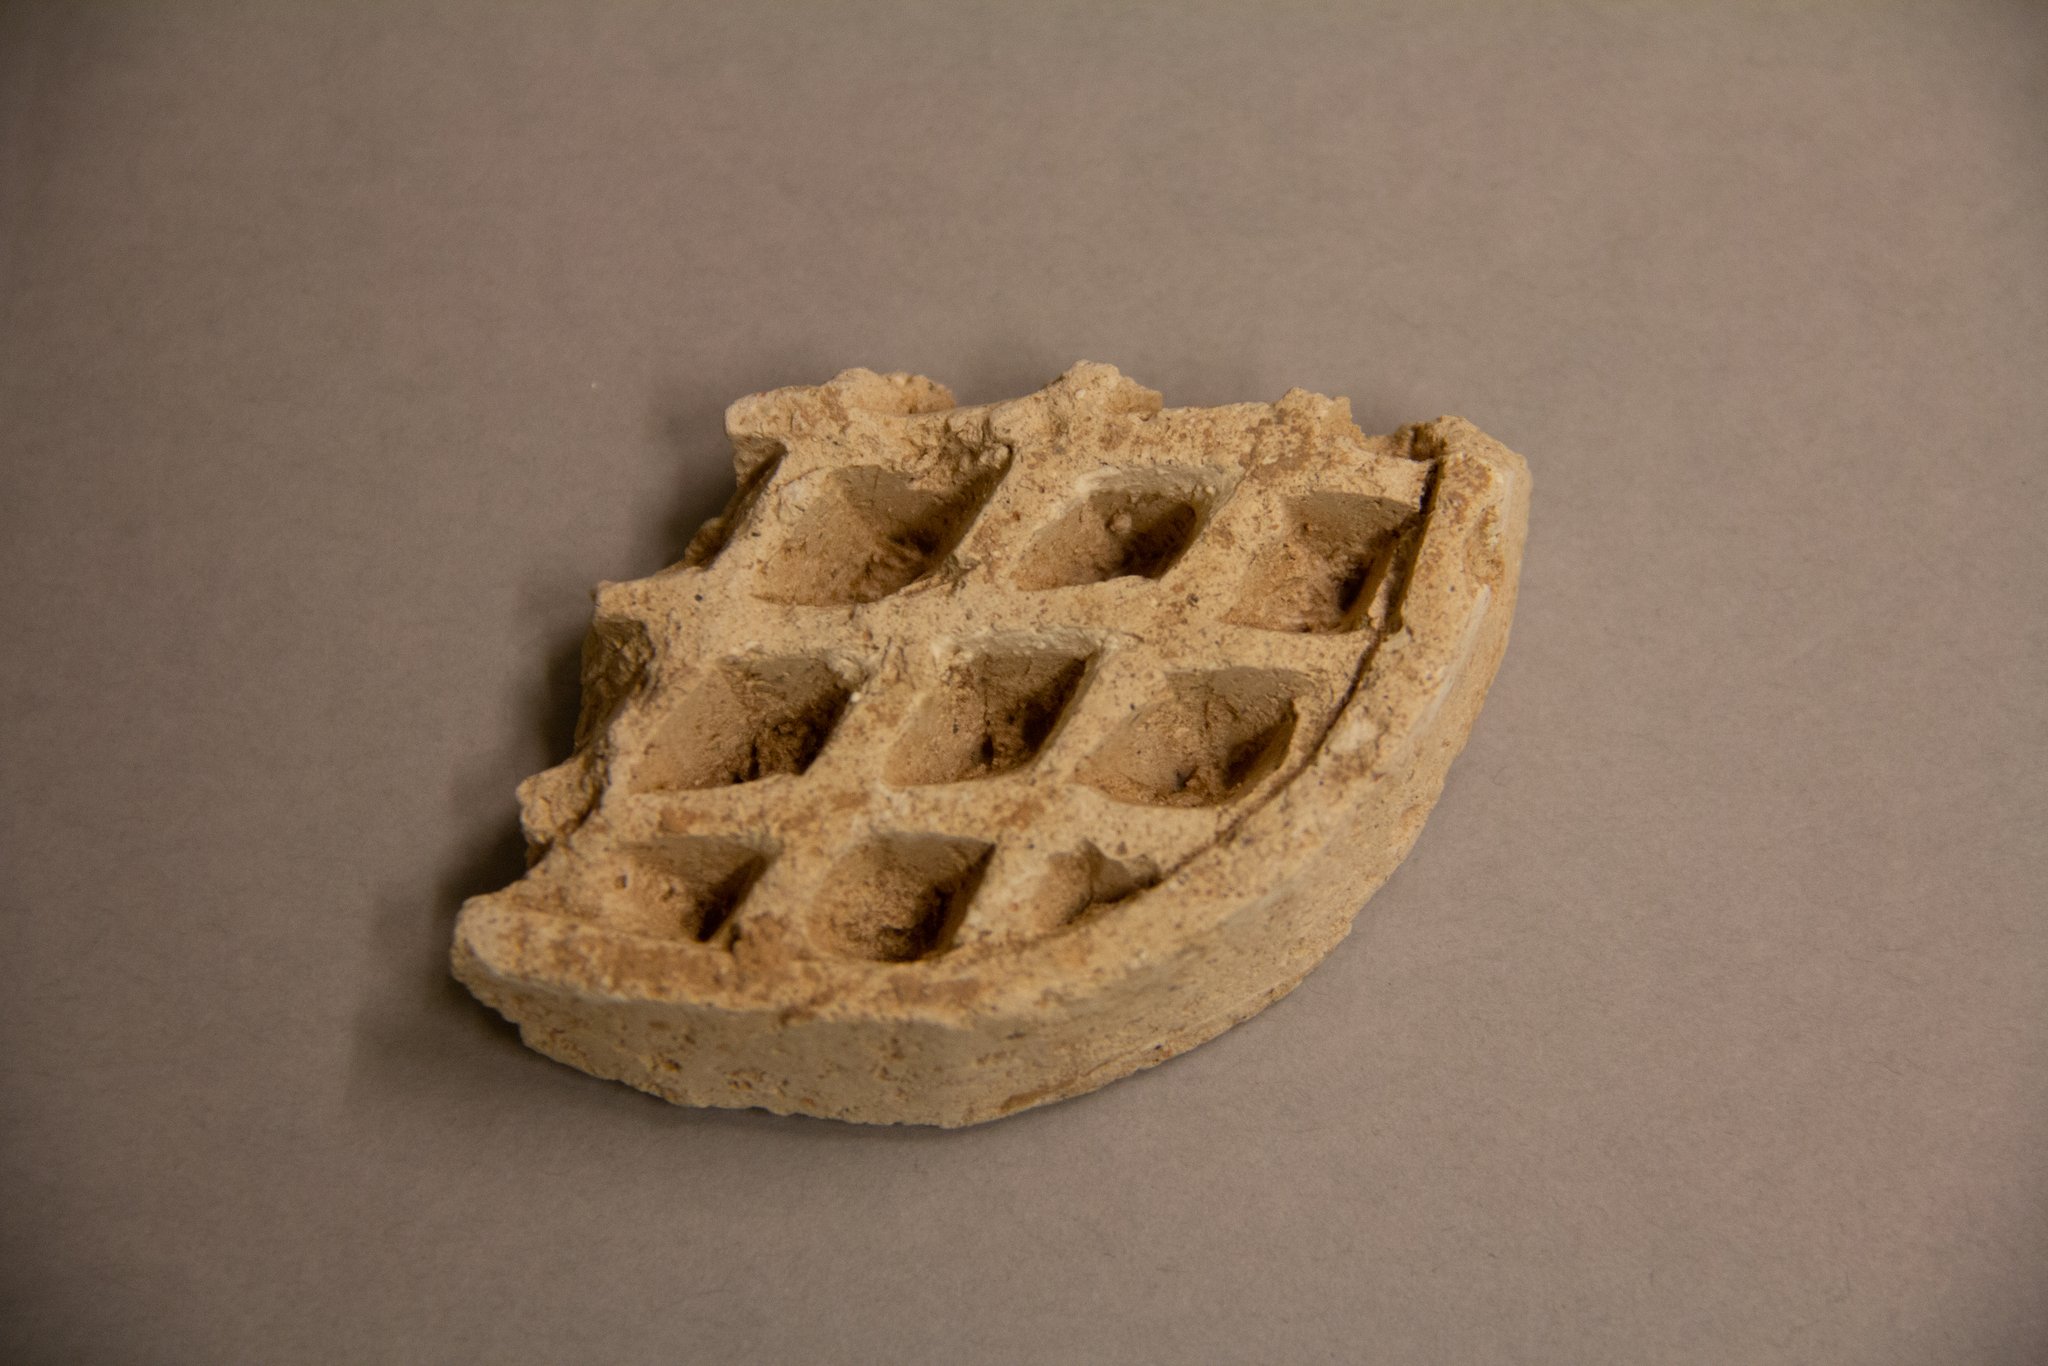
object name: fragment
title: Stucco Fragment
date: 701-1200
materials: plaster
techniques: carving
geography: iran